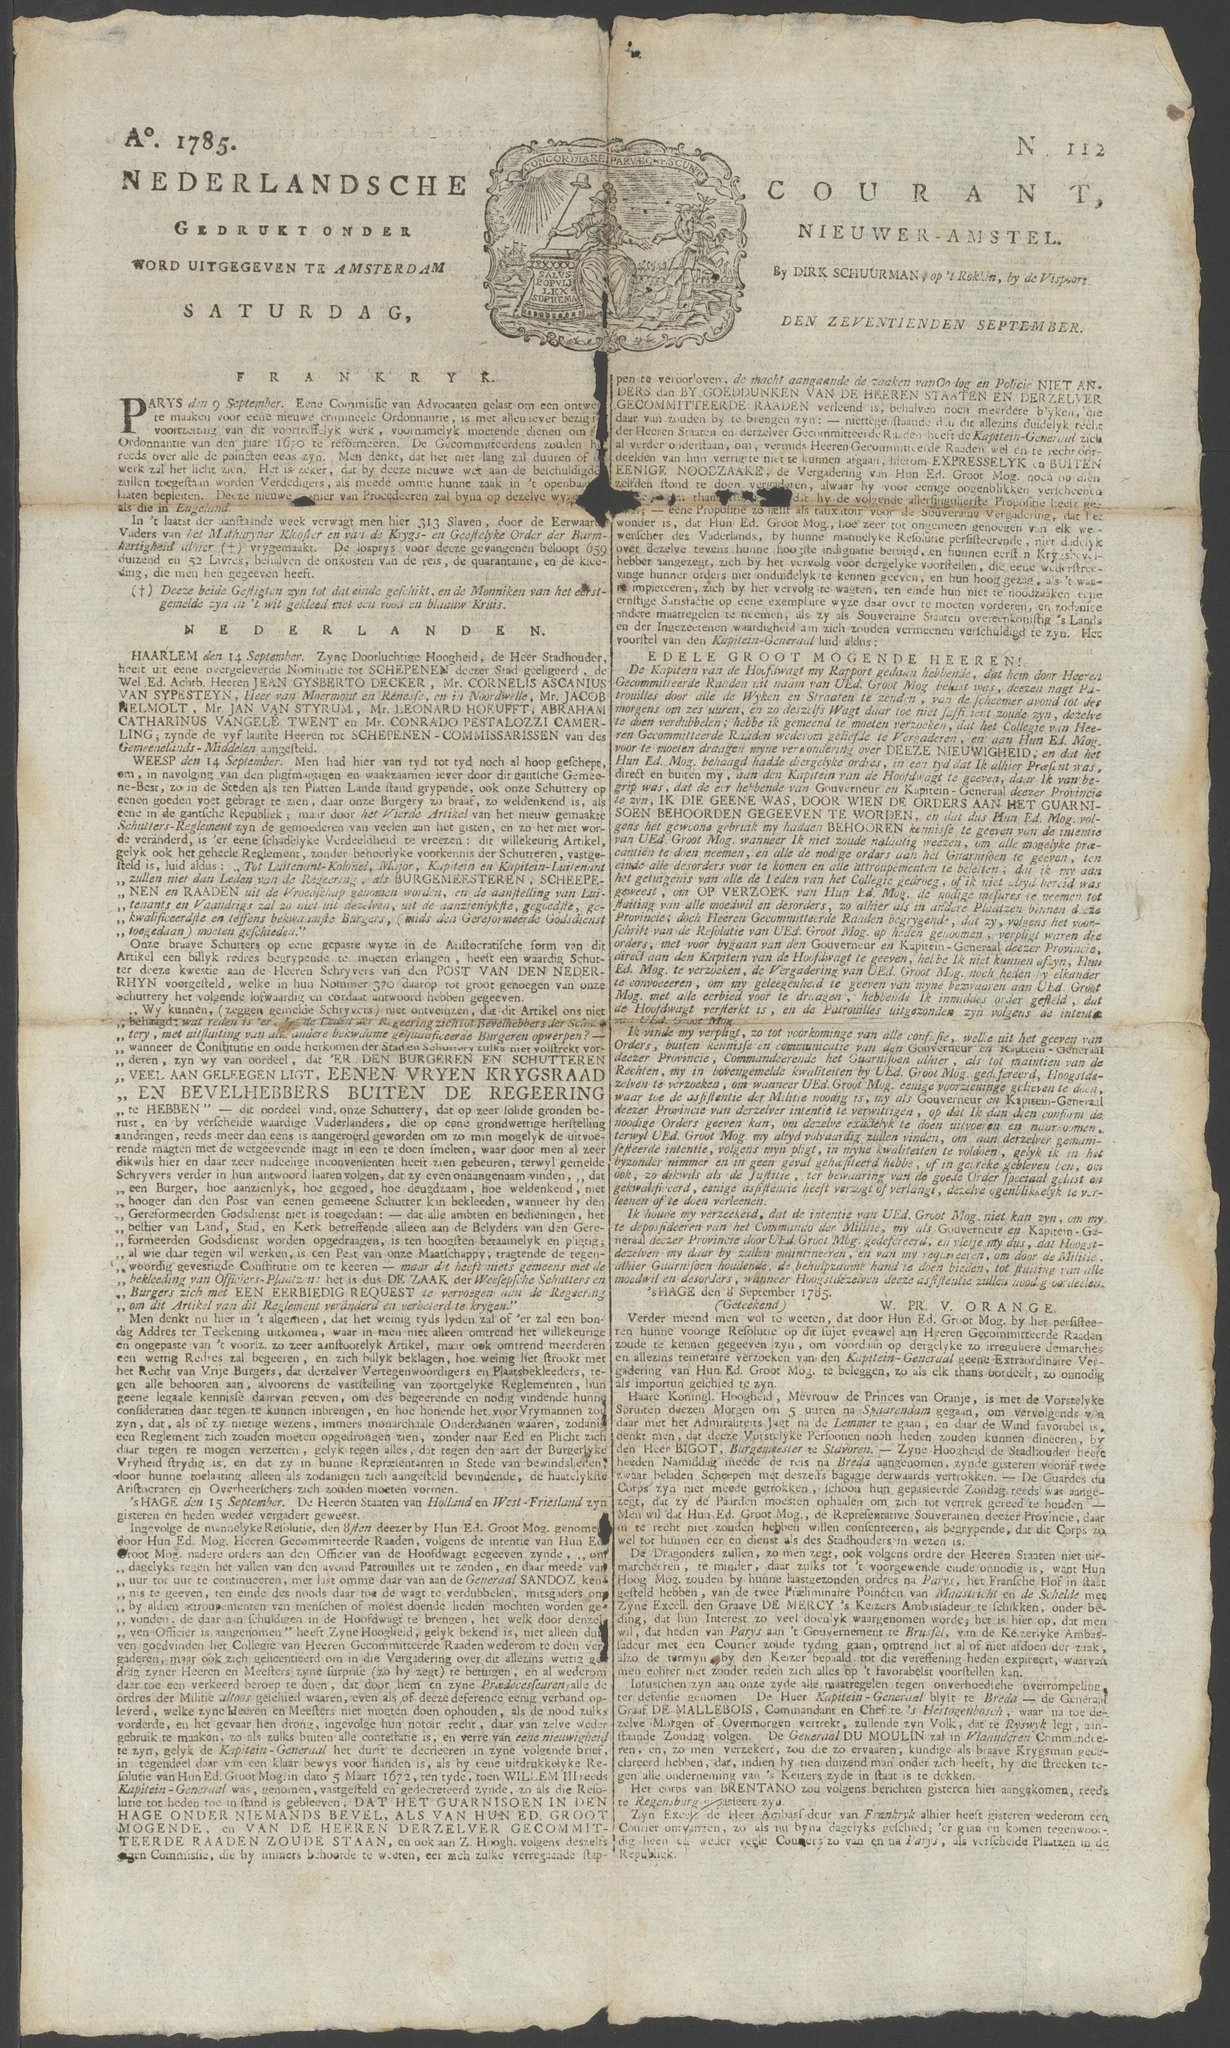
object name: newspaper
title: Nederlandsche Courant, 17 september 1785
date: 1785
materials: paper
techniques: letterpress printing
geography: nieuwer-amstel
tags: newspaper, news-sheet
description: Exemplaar van de krant 'Nederlandsche Courant' van 17 september 1785. Enkelbladig, beide zijden bedrukt. Bovenaan een vignet met de Vrijheid en Mercurius. Onderwerpsrubrieken binnen de Atlas Zeden en Gewoonten: Regeering, Officieele Nieuwsbladen.